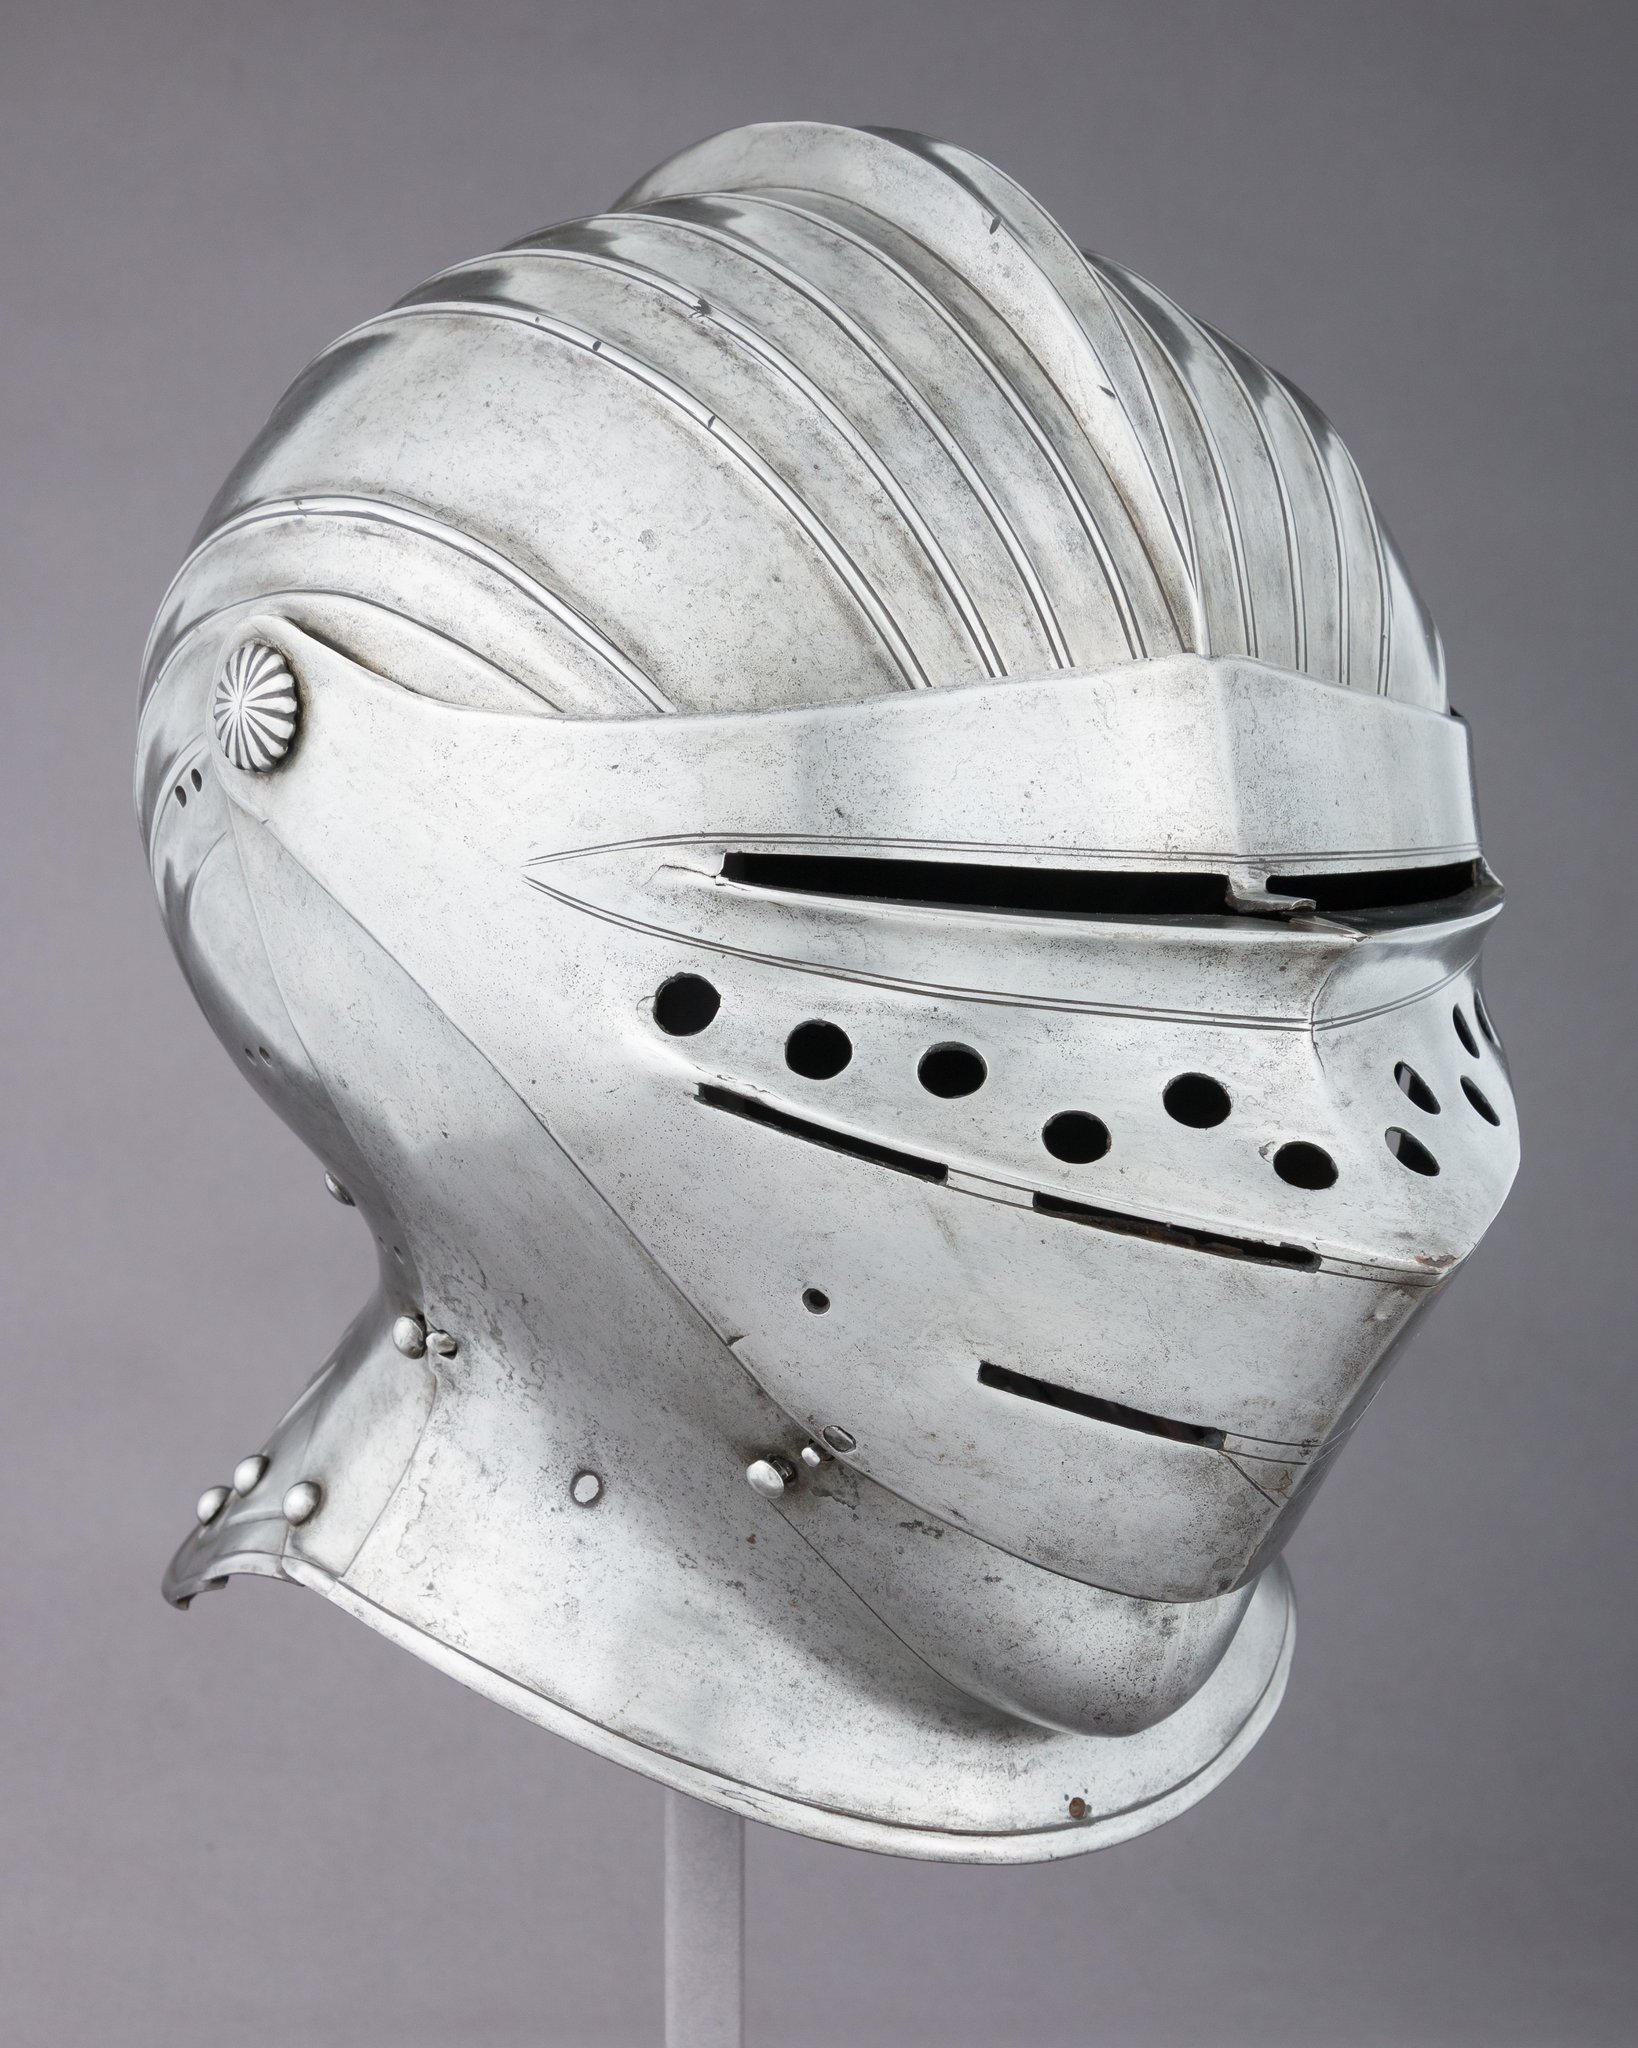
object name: armet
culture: german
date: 1510-1525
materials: steel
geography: germany